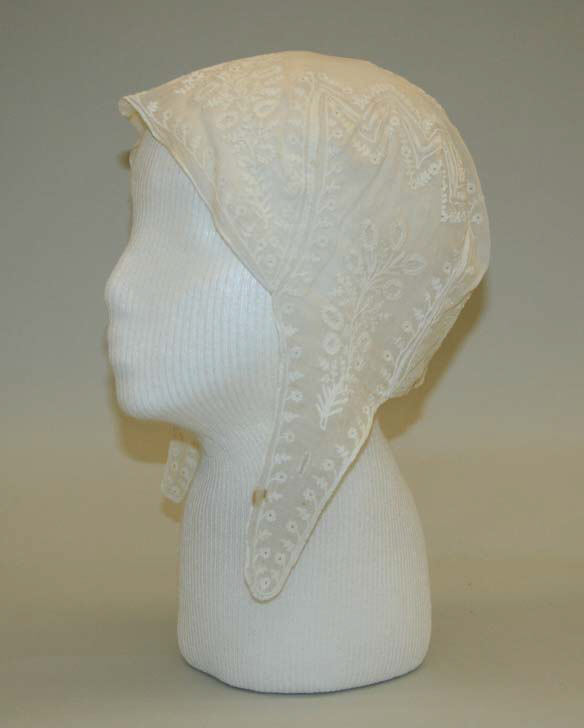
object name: cap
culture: french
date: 1810-1815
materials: cotton